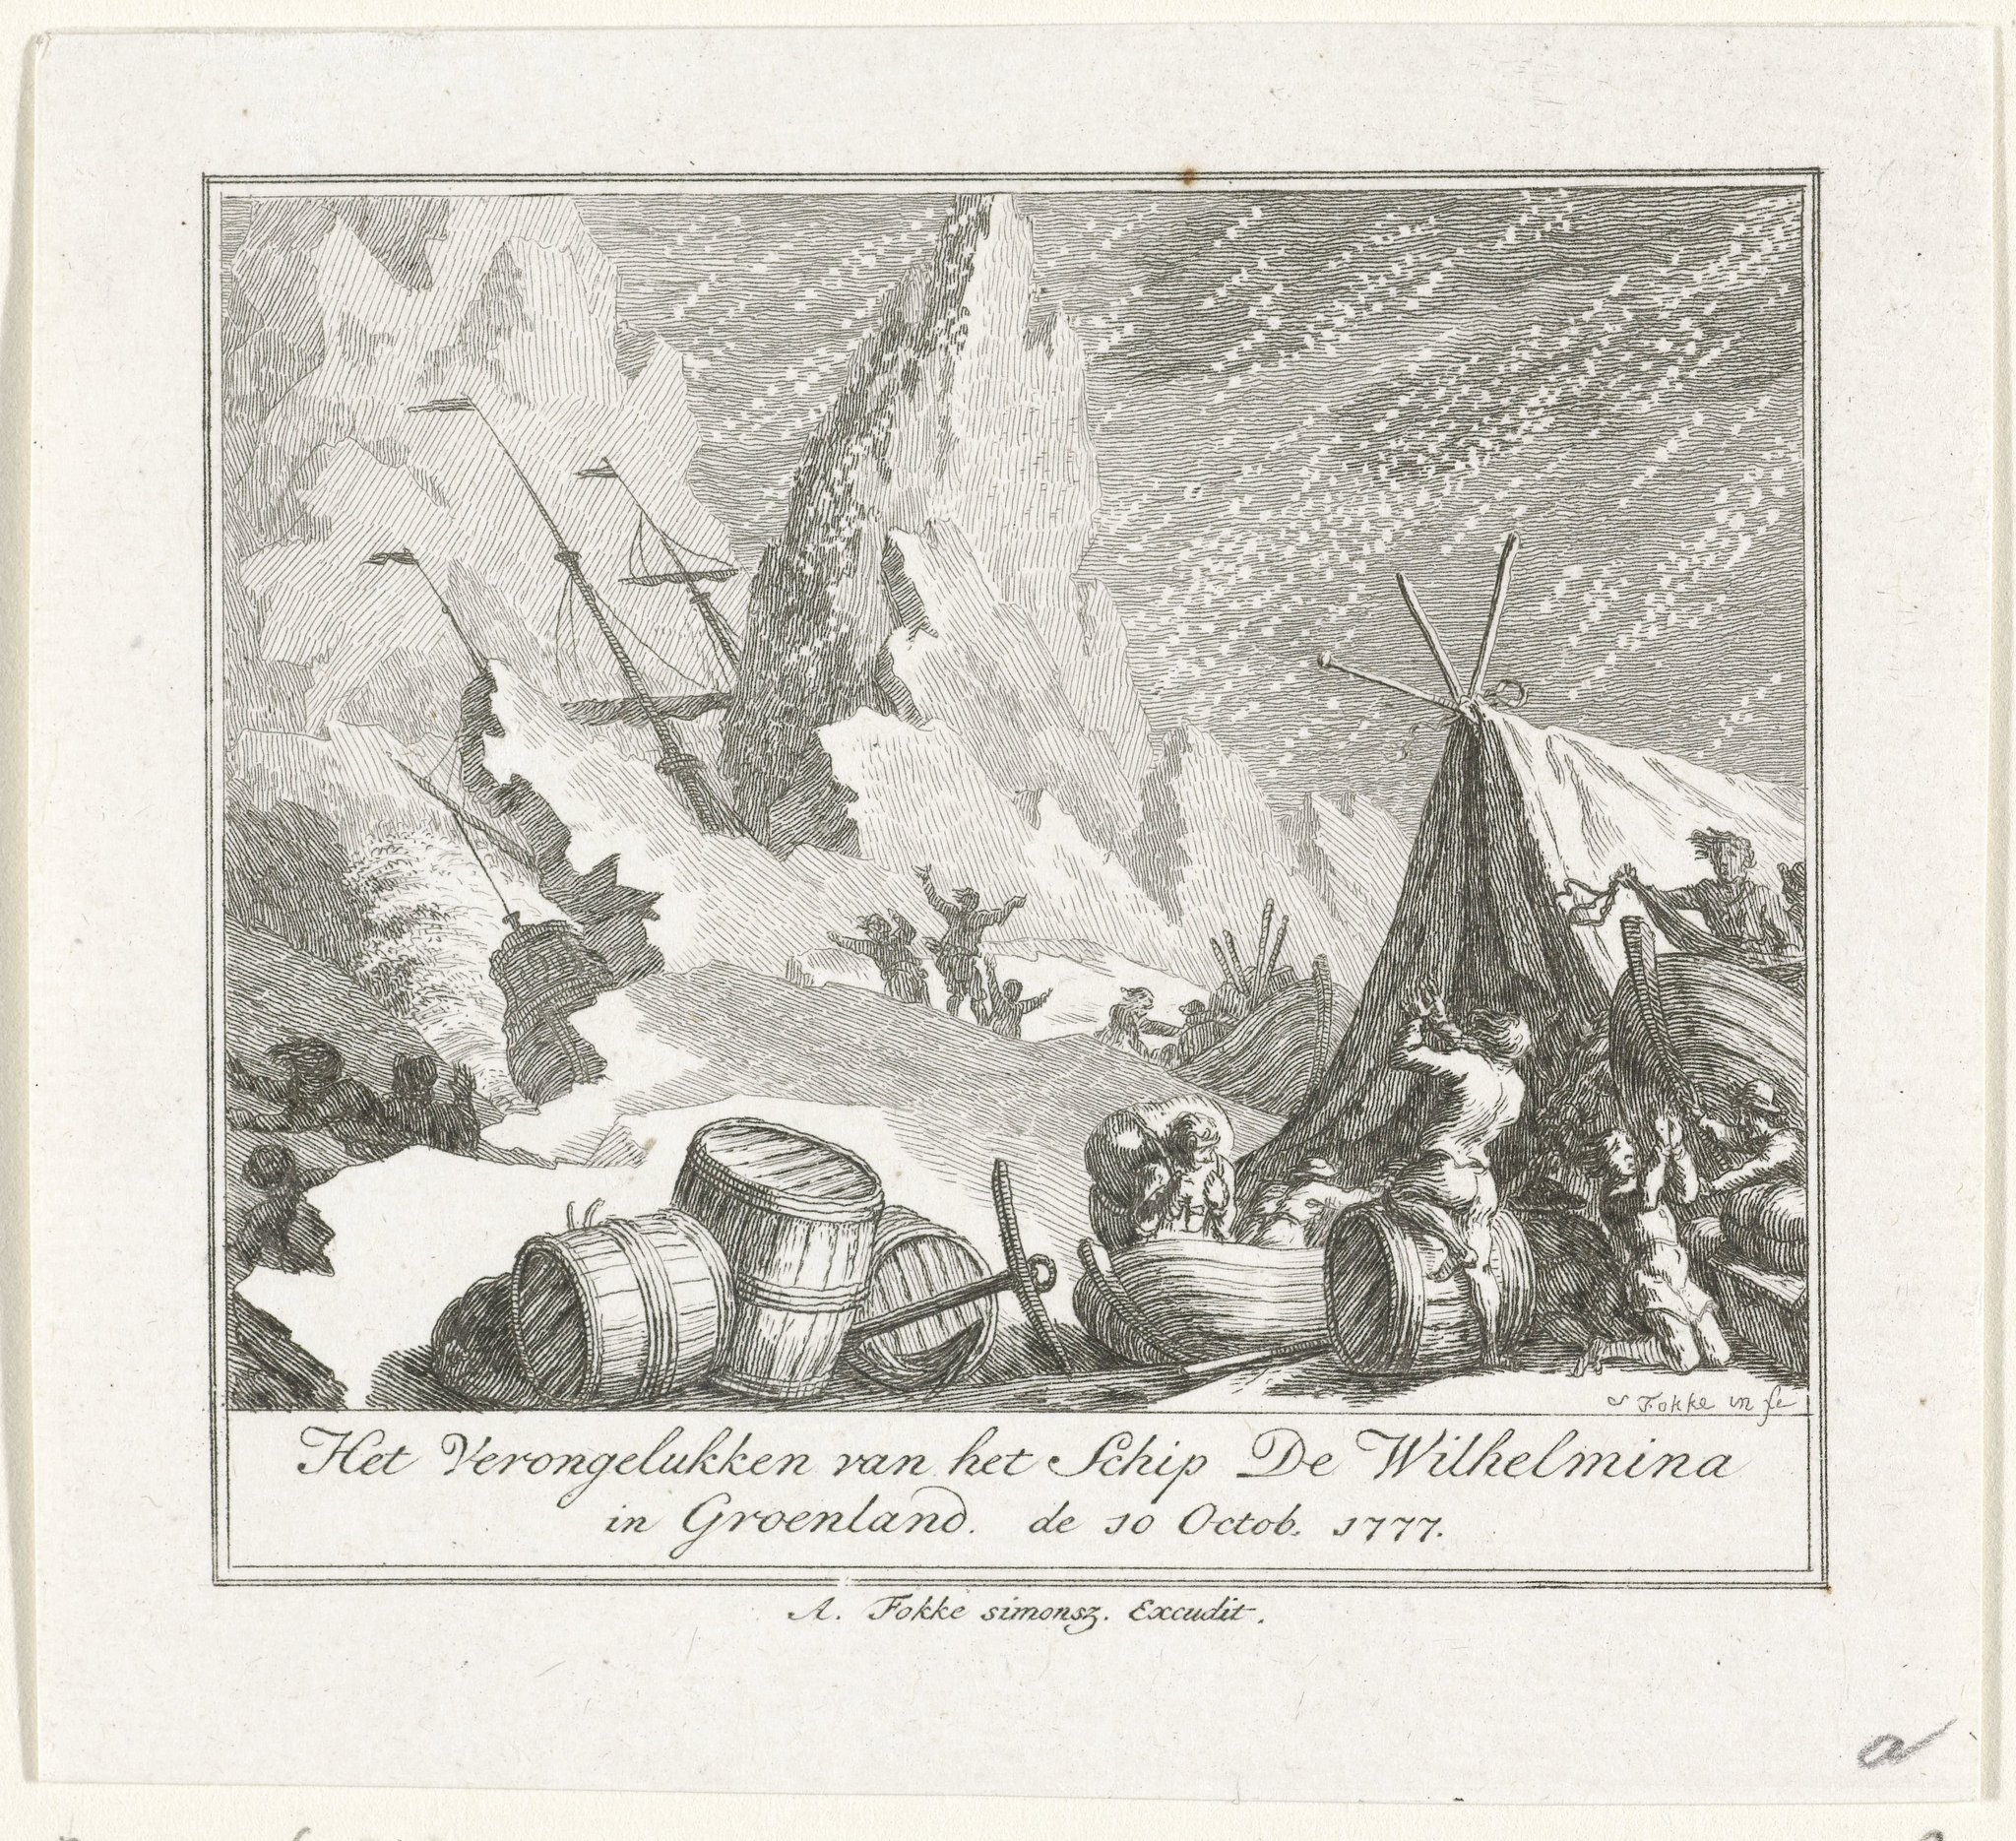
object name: book illustration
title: Verongelukken van het schip De Wilhelmina in Groenland, 1777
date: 1777-1784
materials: paper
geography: amsterdam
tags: shipwreck, landscapes in polar regions, greenland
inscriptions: collector's mark: Lugt 2228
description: Voorstelling uit de vaderlandse geschiedenis. Figuren in een ijslandschap bij een tent. In de verte ligt achter een grote ijsschots de verongelukte boot. Voorstelling bovenaan genummerd: XVI.